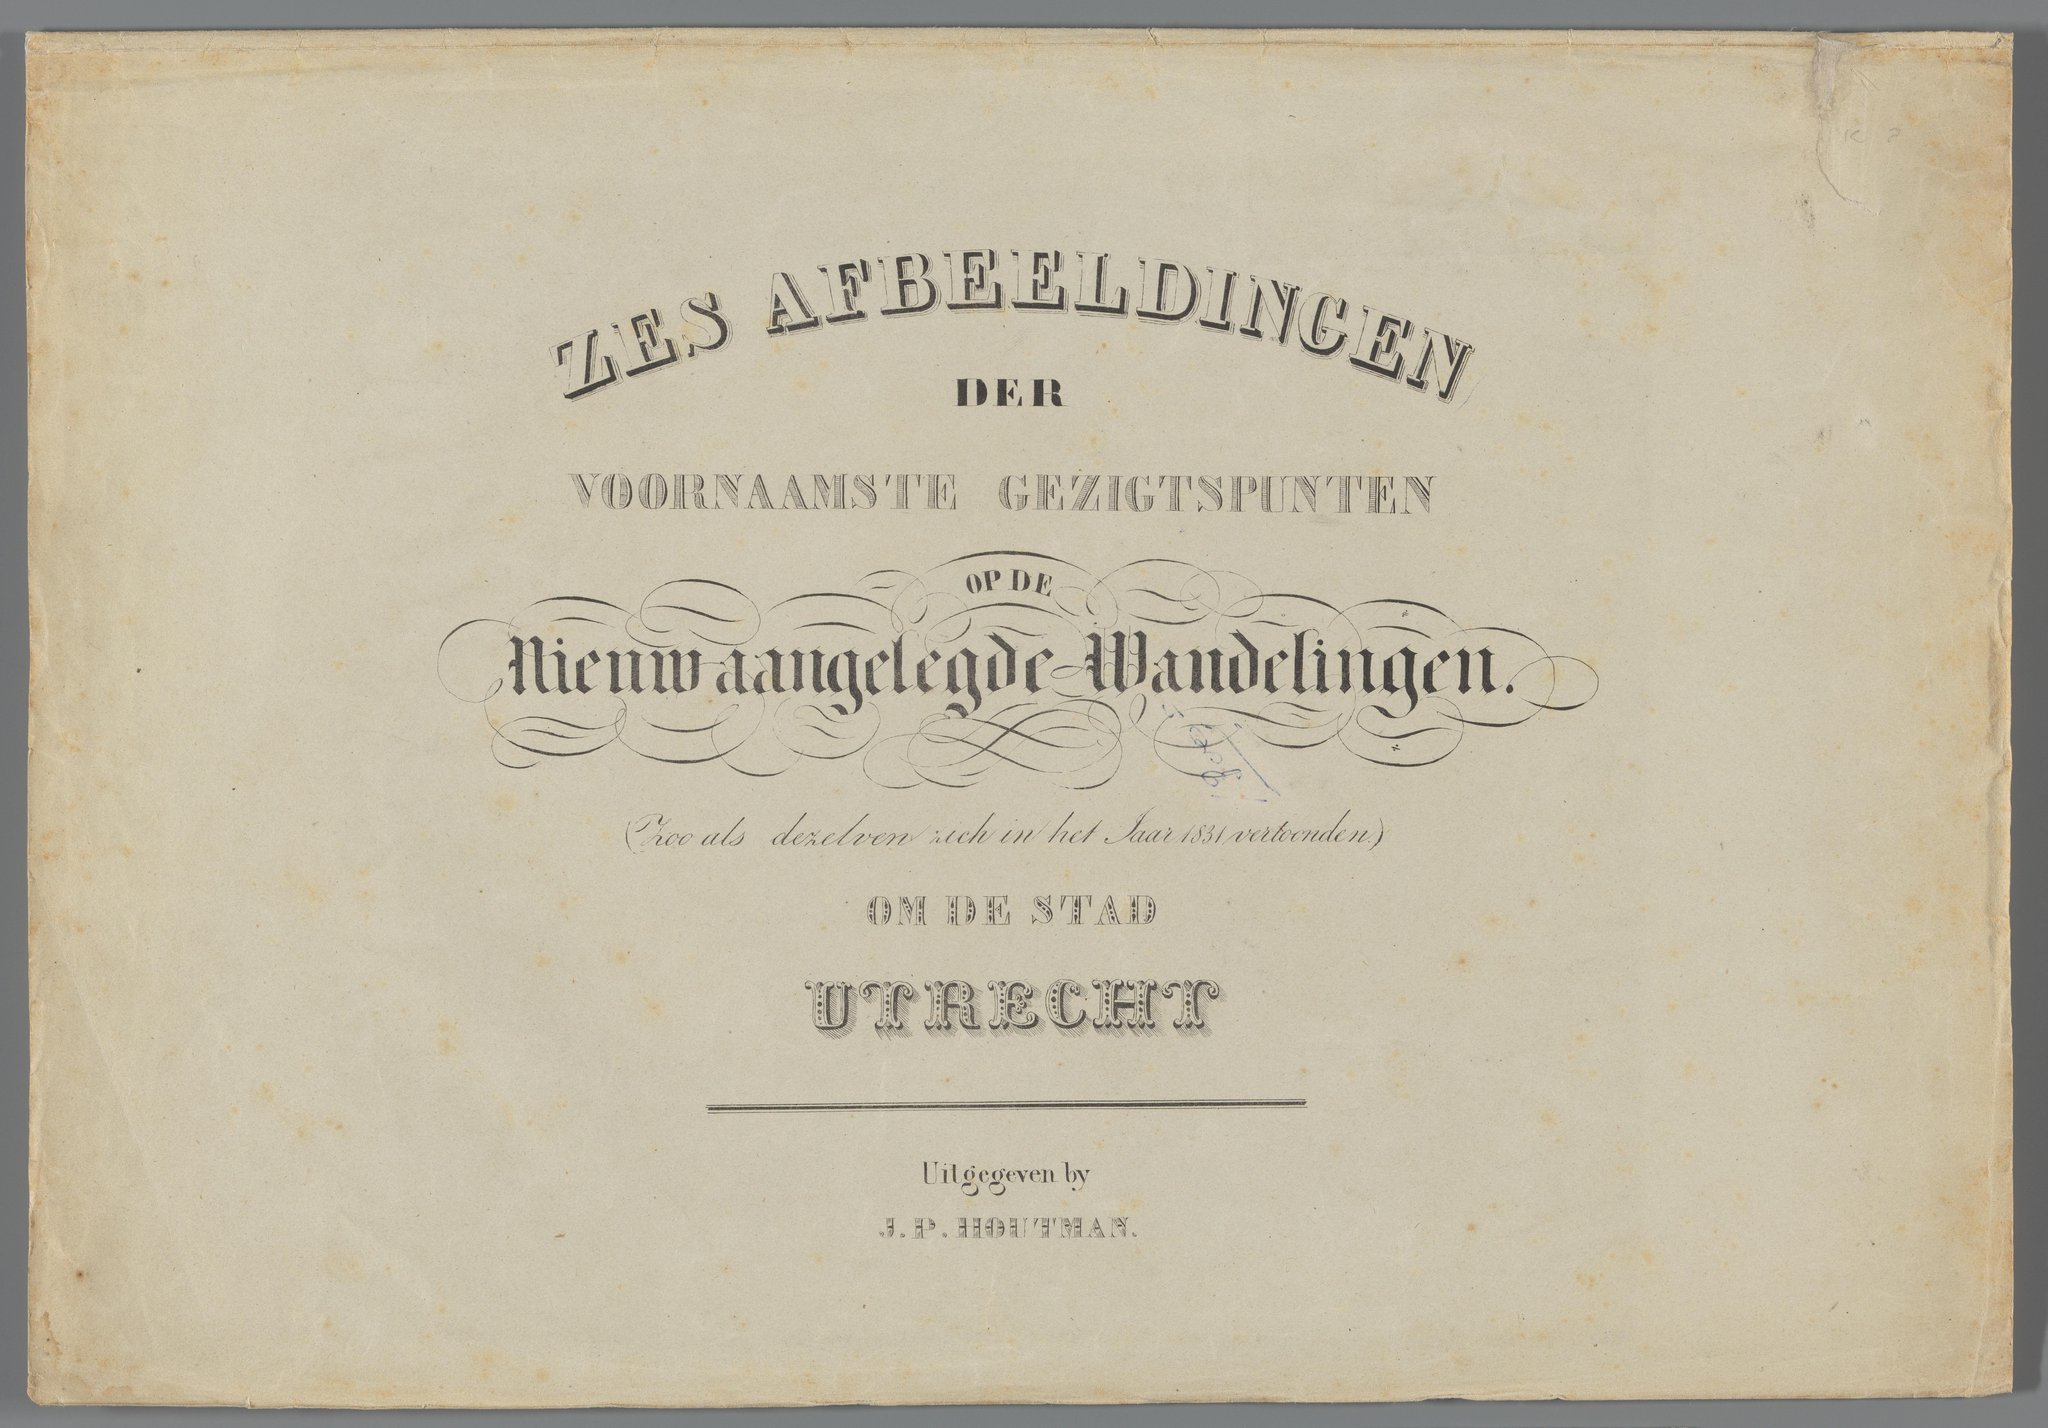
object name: wrapper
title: Zes afbeeldingen der voornaamste gezigtspunten op de Nieuw aangelegde Wandelingen. (Zoo als dezelven zich in het Jaar 1831 vertoonden) om de stad Utrecht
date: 1831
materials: ink, paper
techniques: lithograph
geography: netherlands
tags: utrecht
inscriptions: date